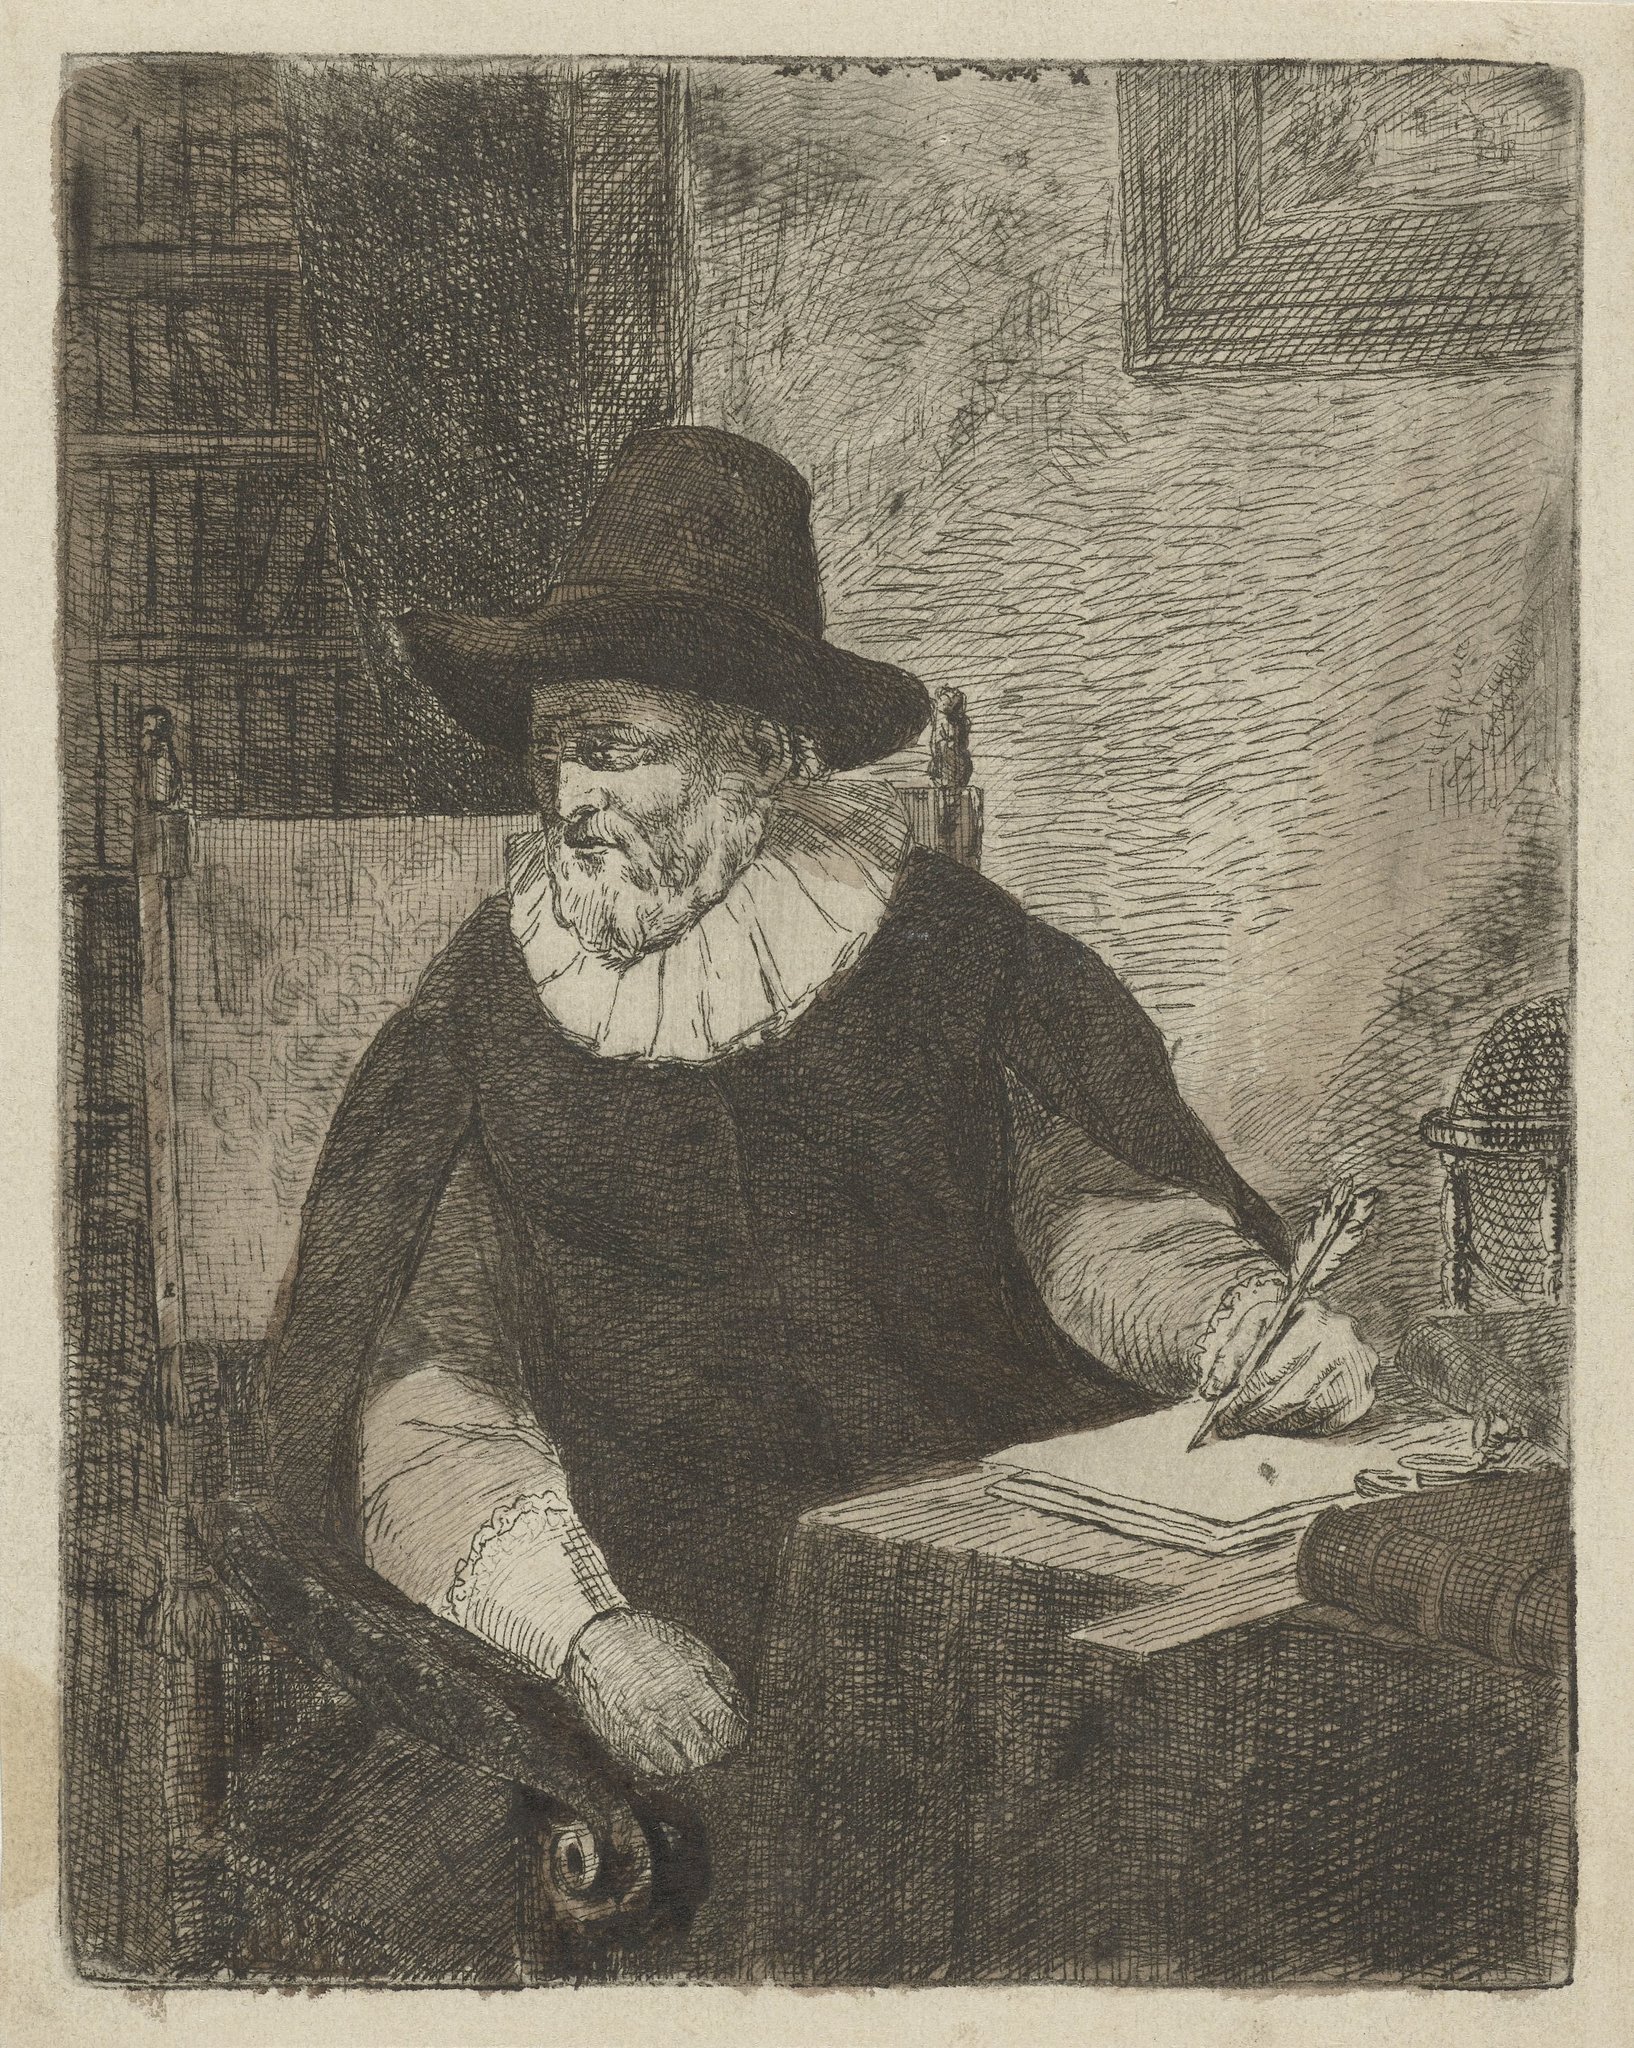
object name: print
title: Man in een studeerkamer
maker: david van der kellen (1804-1879)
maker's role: die cutter, draughtsman, print maker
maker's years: 1804-1879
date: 1814-1859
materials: paper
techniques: brush, etching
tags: globe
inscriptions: collector's mark: Lugt 2228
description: Een oudere man met schrijfveer in de hand zit aan zijn bureau, waarop een globe. Achter hem een boekenkast.